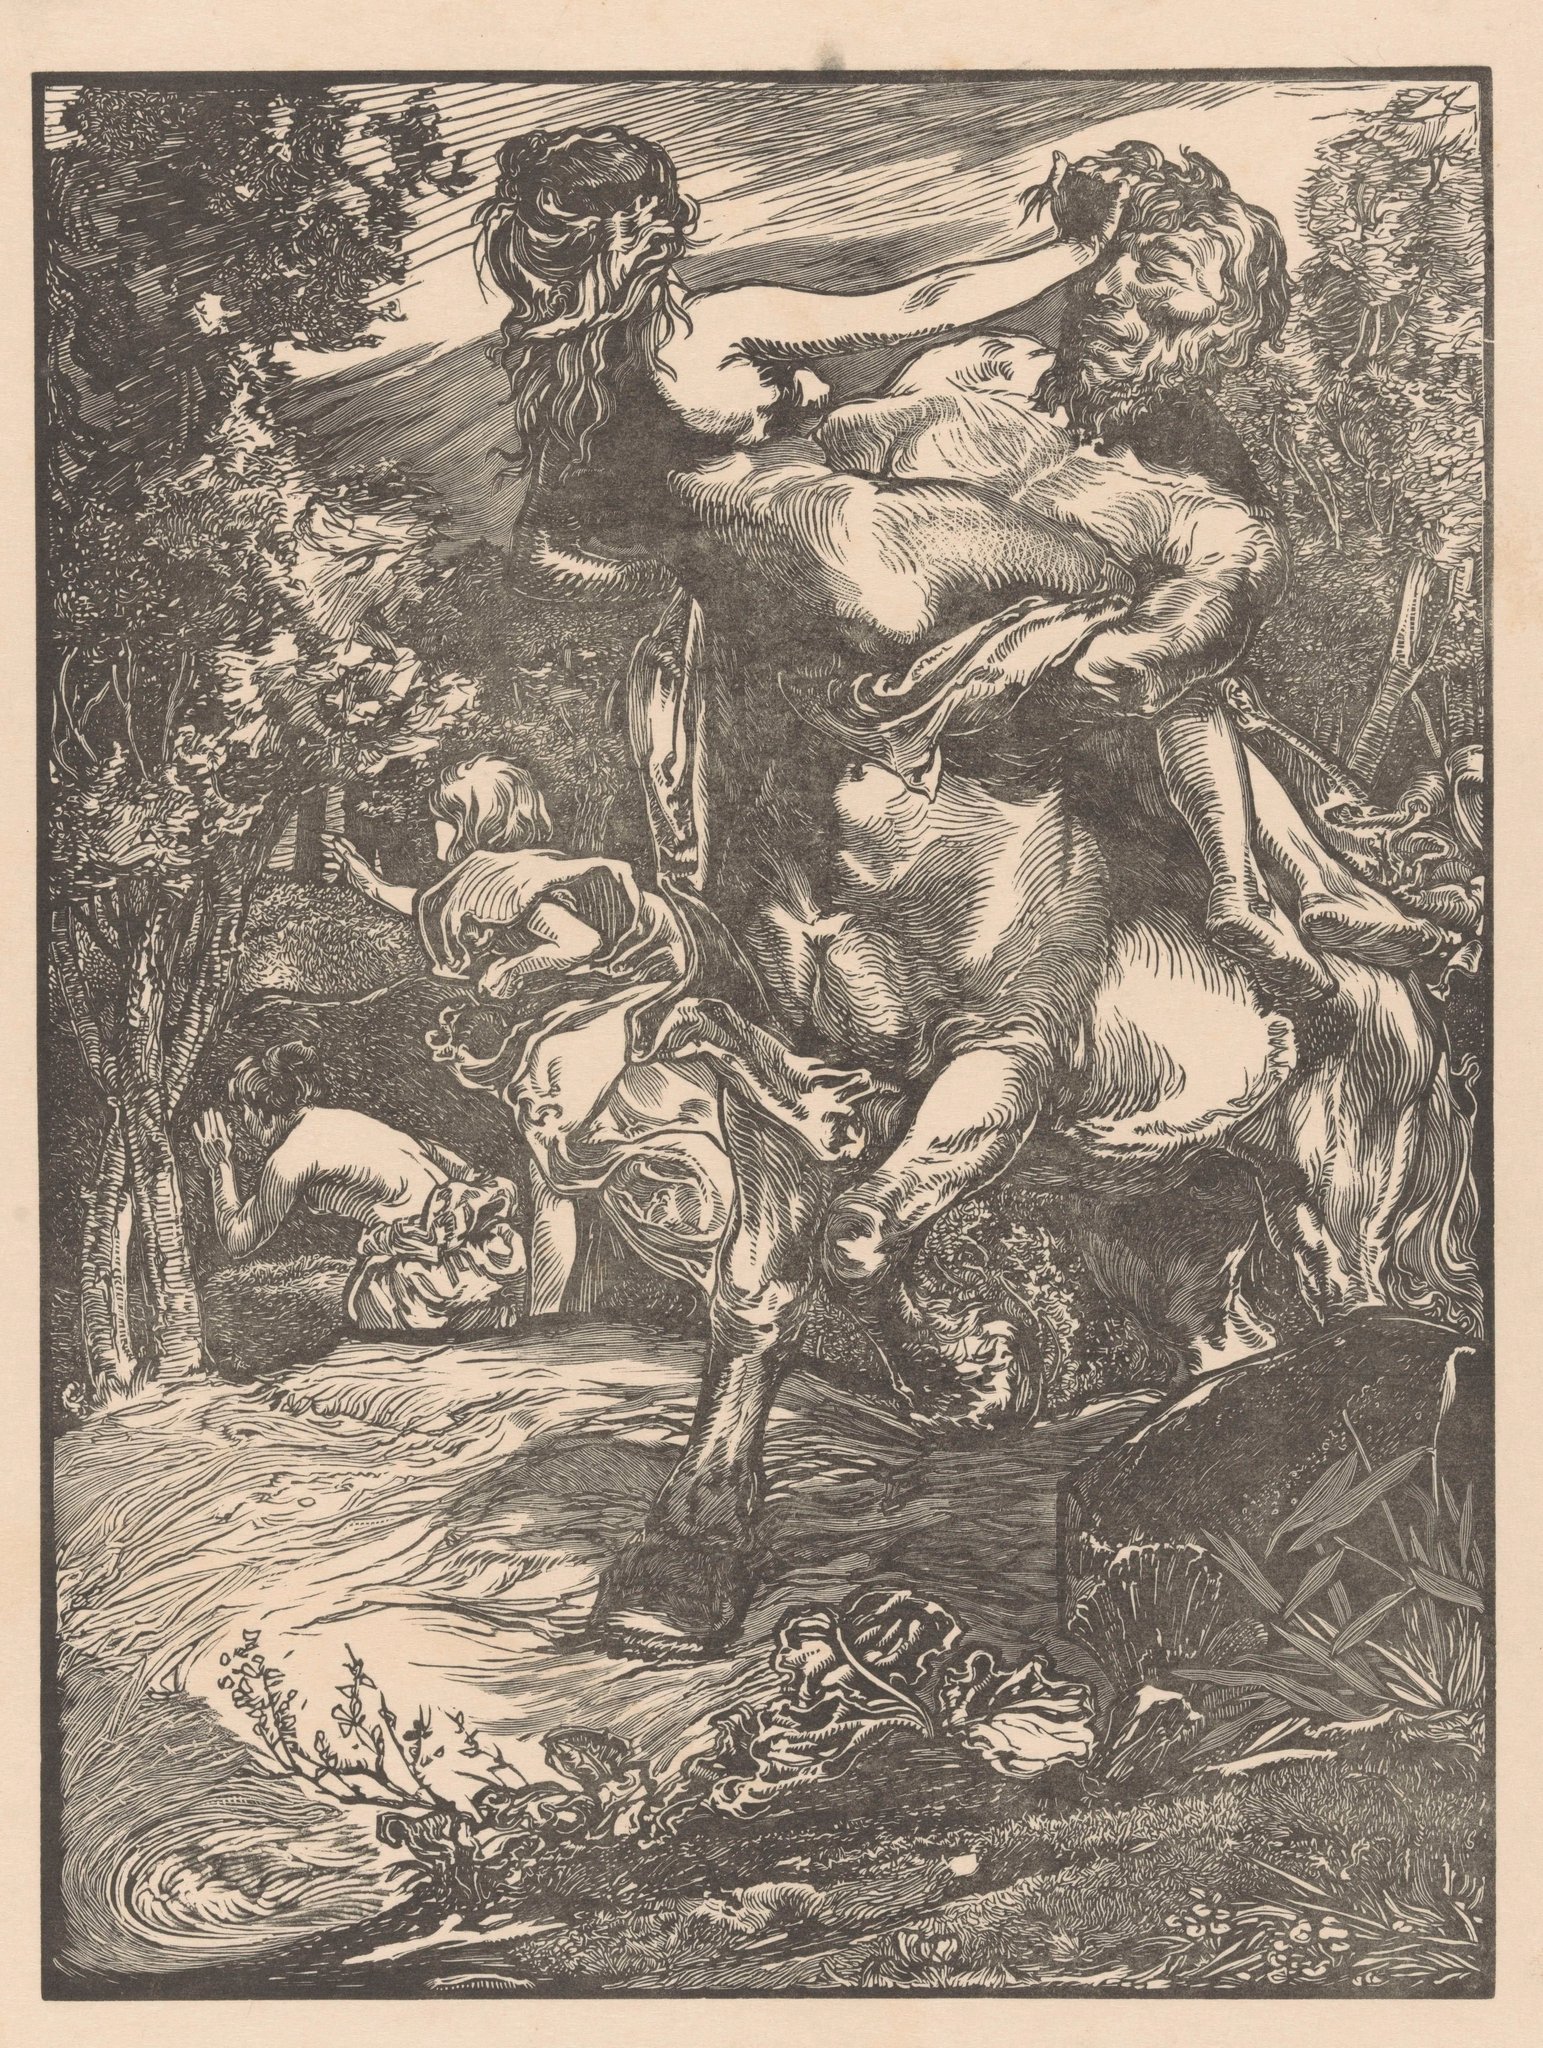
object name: print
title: Ontvoering van Deïanira door Nessus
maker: johannes josephus aarts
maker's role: draughtsman, print maker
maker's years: 1871-1934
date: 1881-1934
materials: paper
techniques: woodcut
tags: centaurs, nessus, forest, wood, brook, abducting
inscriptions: collector's mark: Lugt 2228, collector's mark: Lugt 2760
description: De centaur Nessus waadt door de rivier de Evenus met een vrouw, Deïanira, in zijn armen. Ze duwt met een van haar armen tegen zijn hoofd en kijkt naar twee andere vrouwen die op de achtergrond wegrennen.